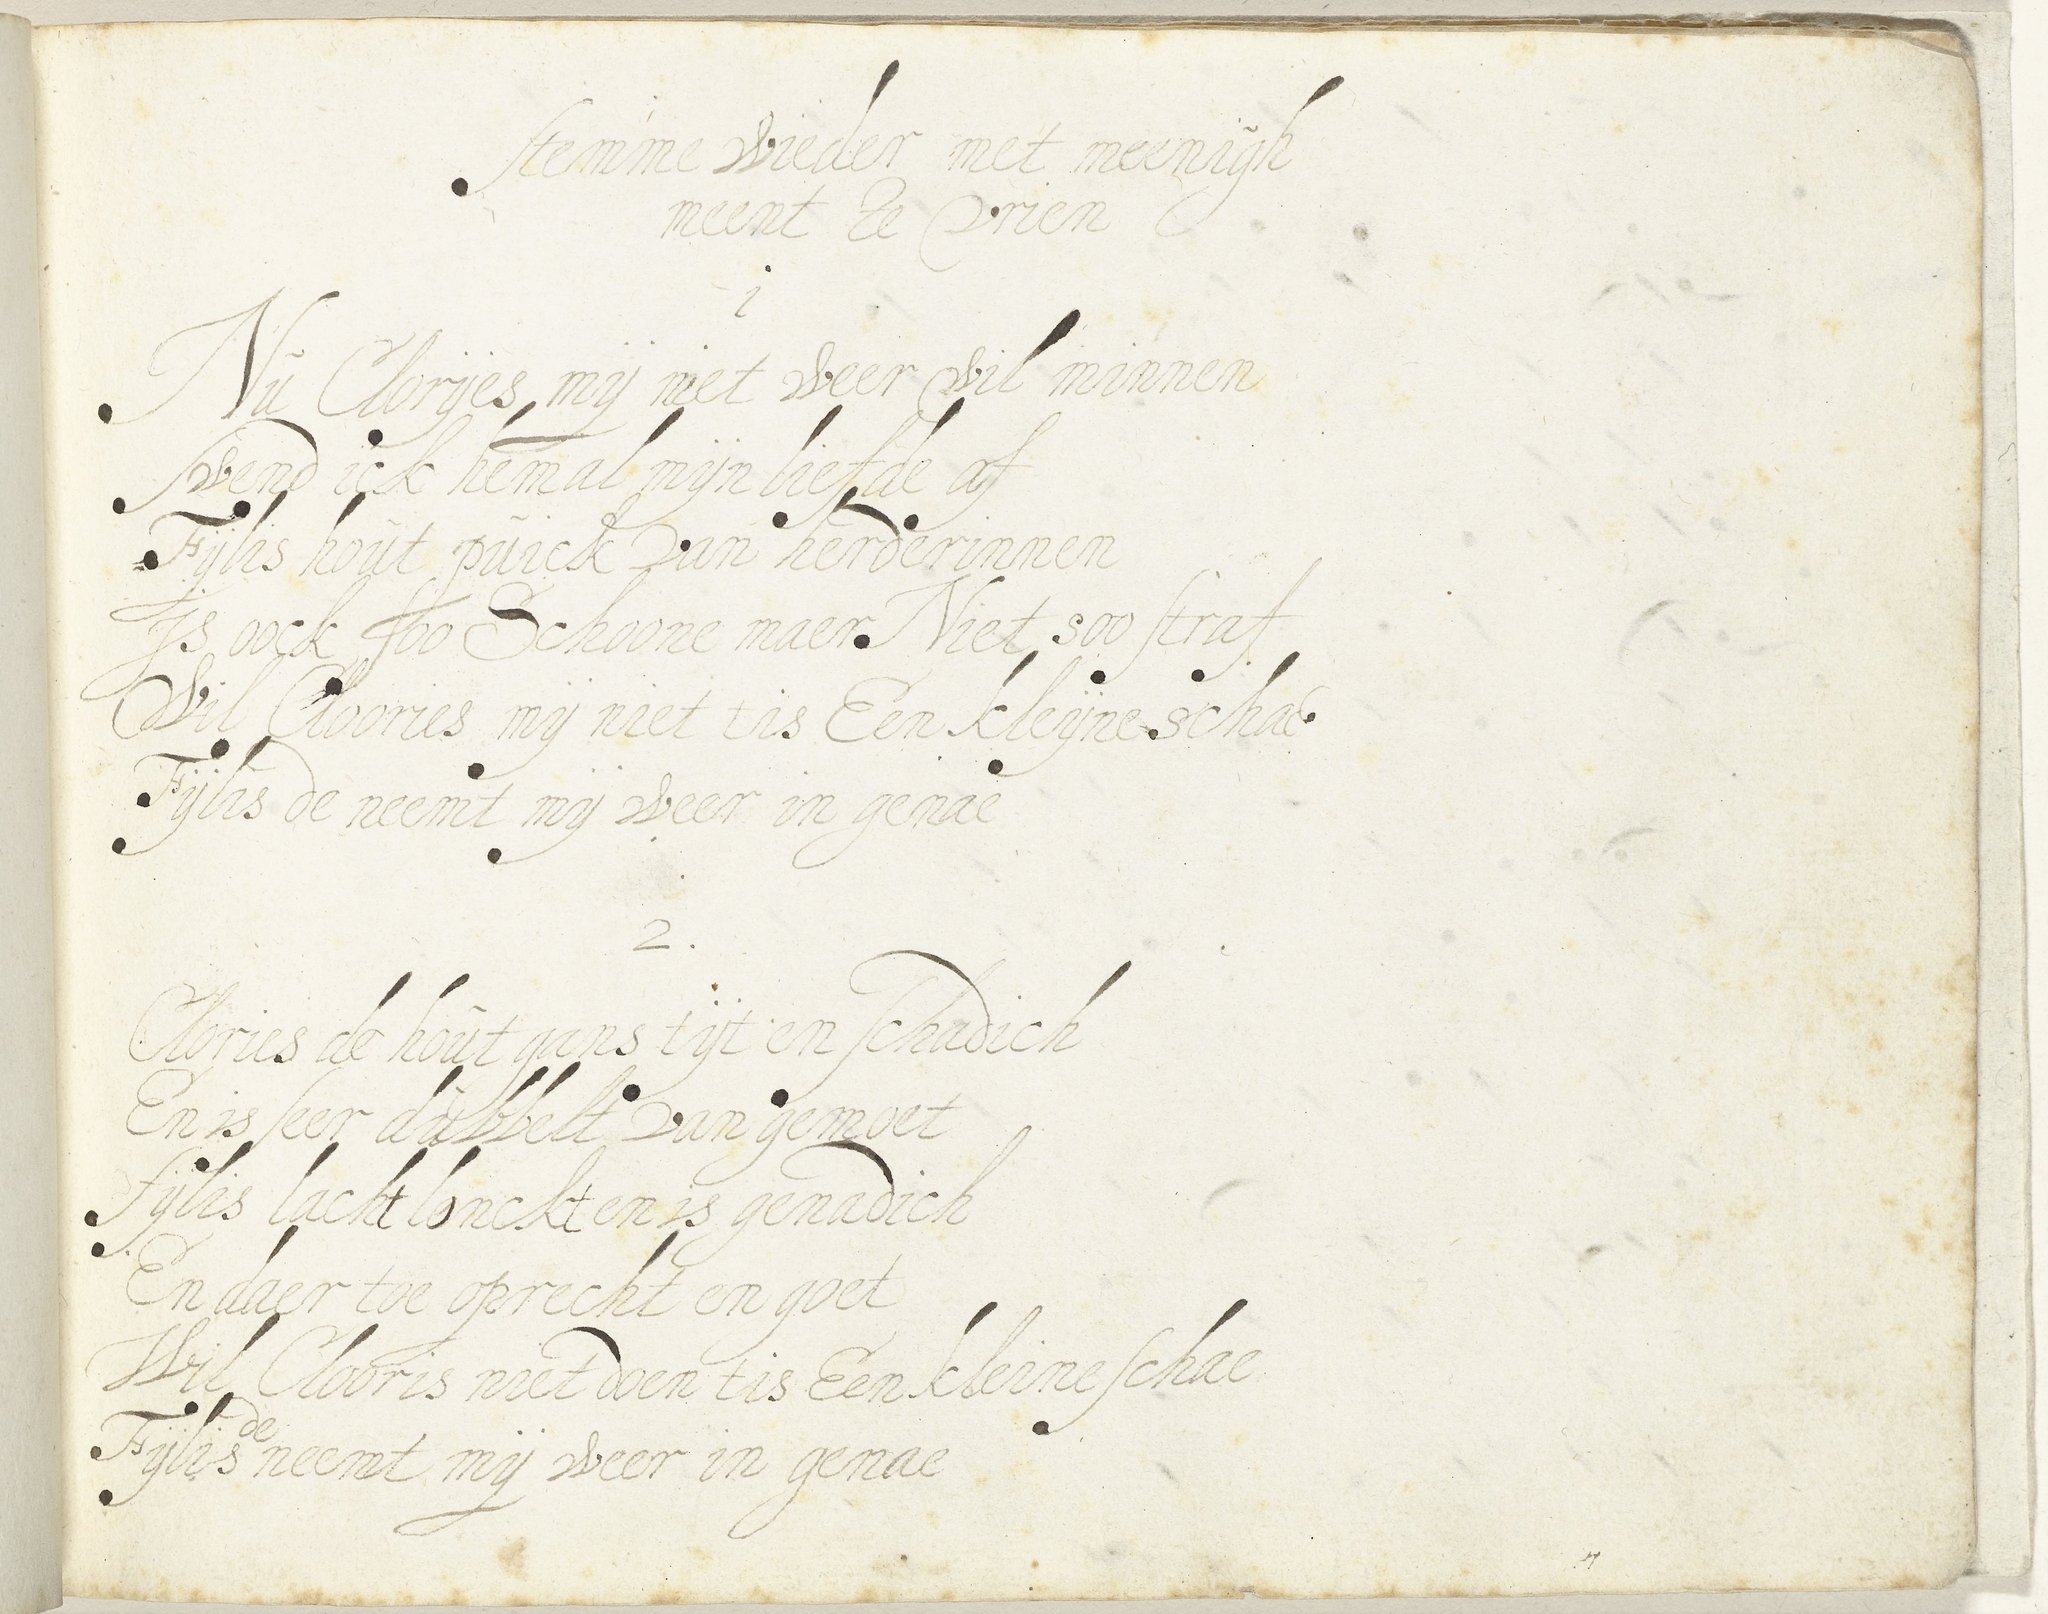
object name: poem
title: Gedicht over een oude en een nieuwe liefde (deel 1)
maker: gesina ter borch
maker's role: draughtsman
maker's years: 1633-1690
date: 1646-1650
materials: ink, paper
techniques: calligraphy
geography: zwolle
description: Liefdesklacht op de melodie van Wieder met meenigh meent te vrien.